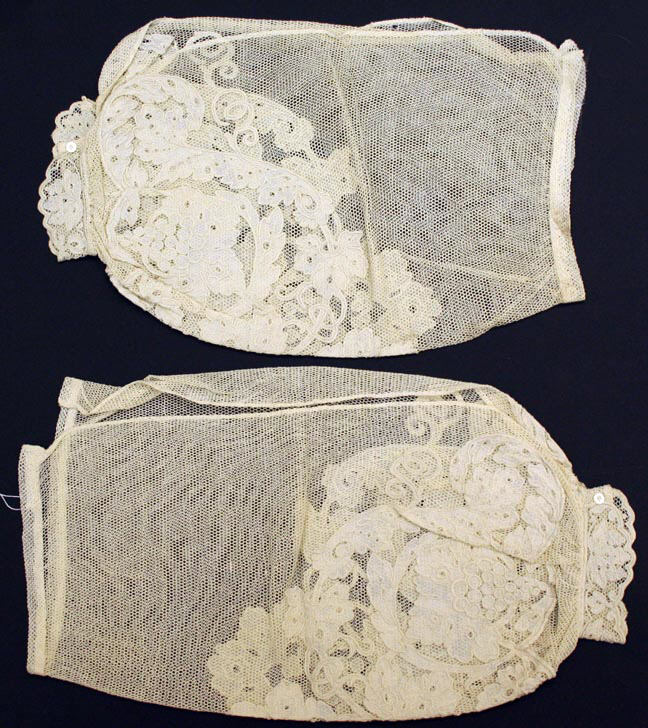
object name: undersleeves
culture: british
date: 1850-1865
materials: cotton, linen